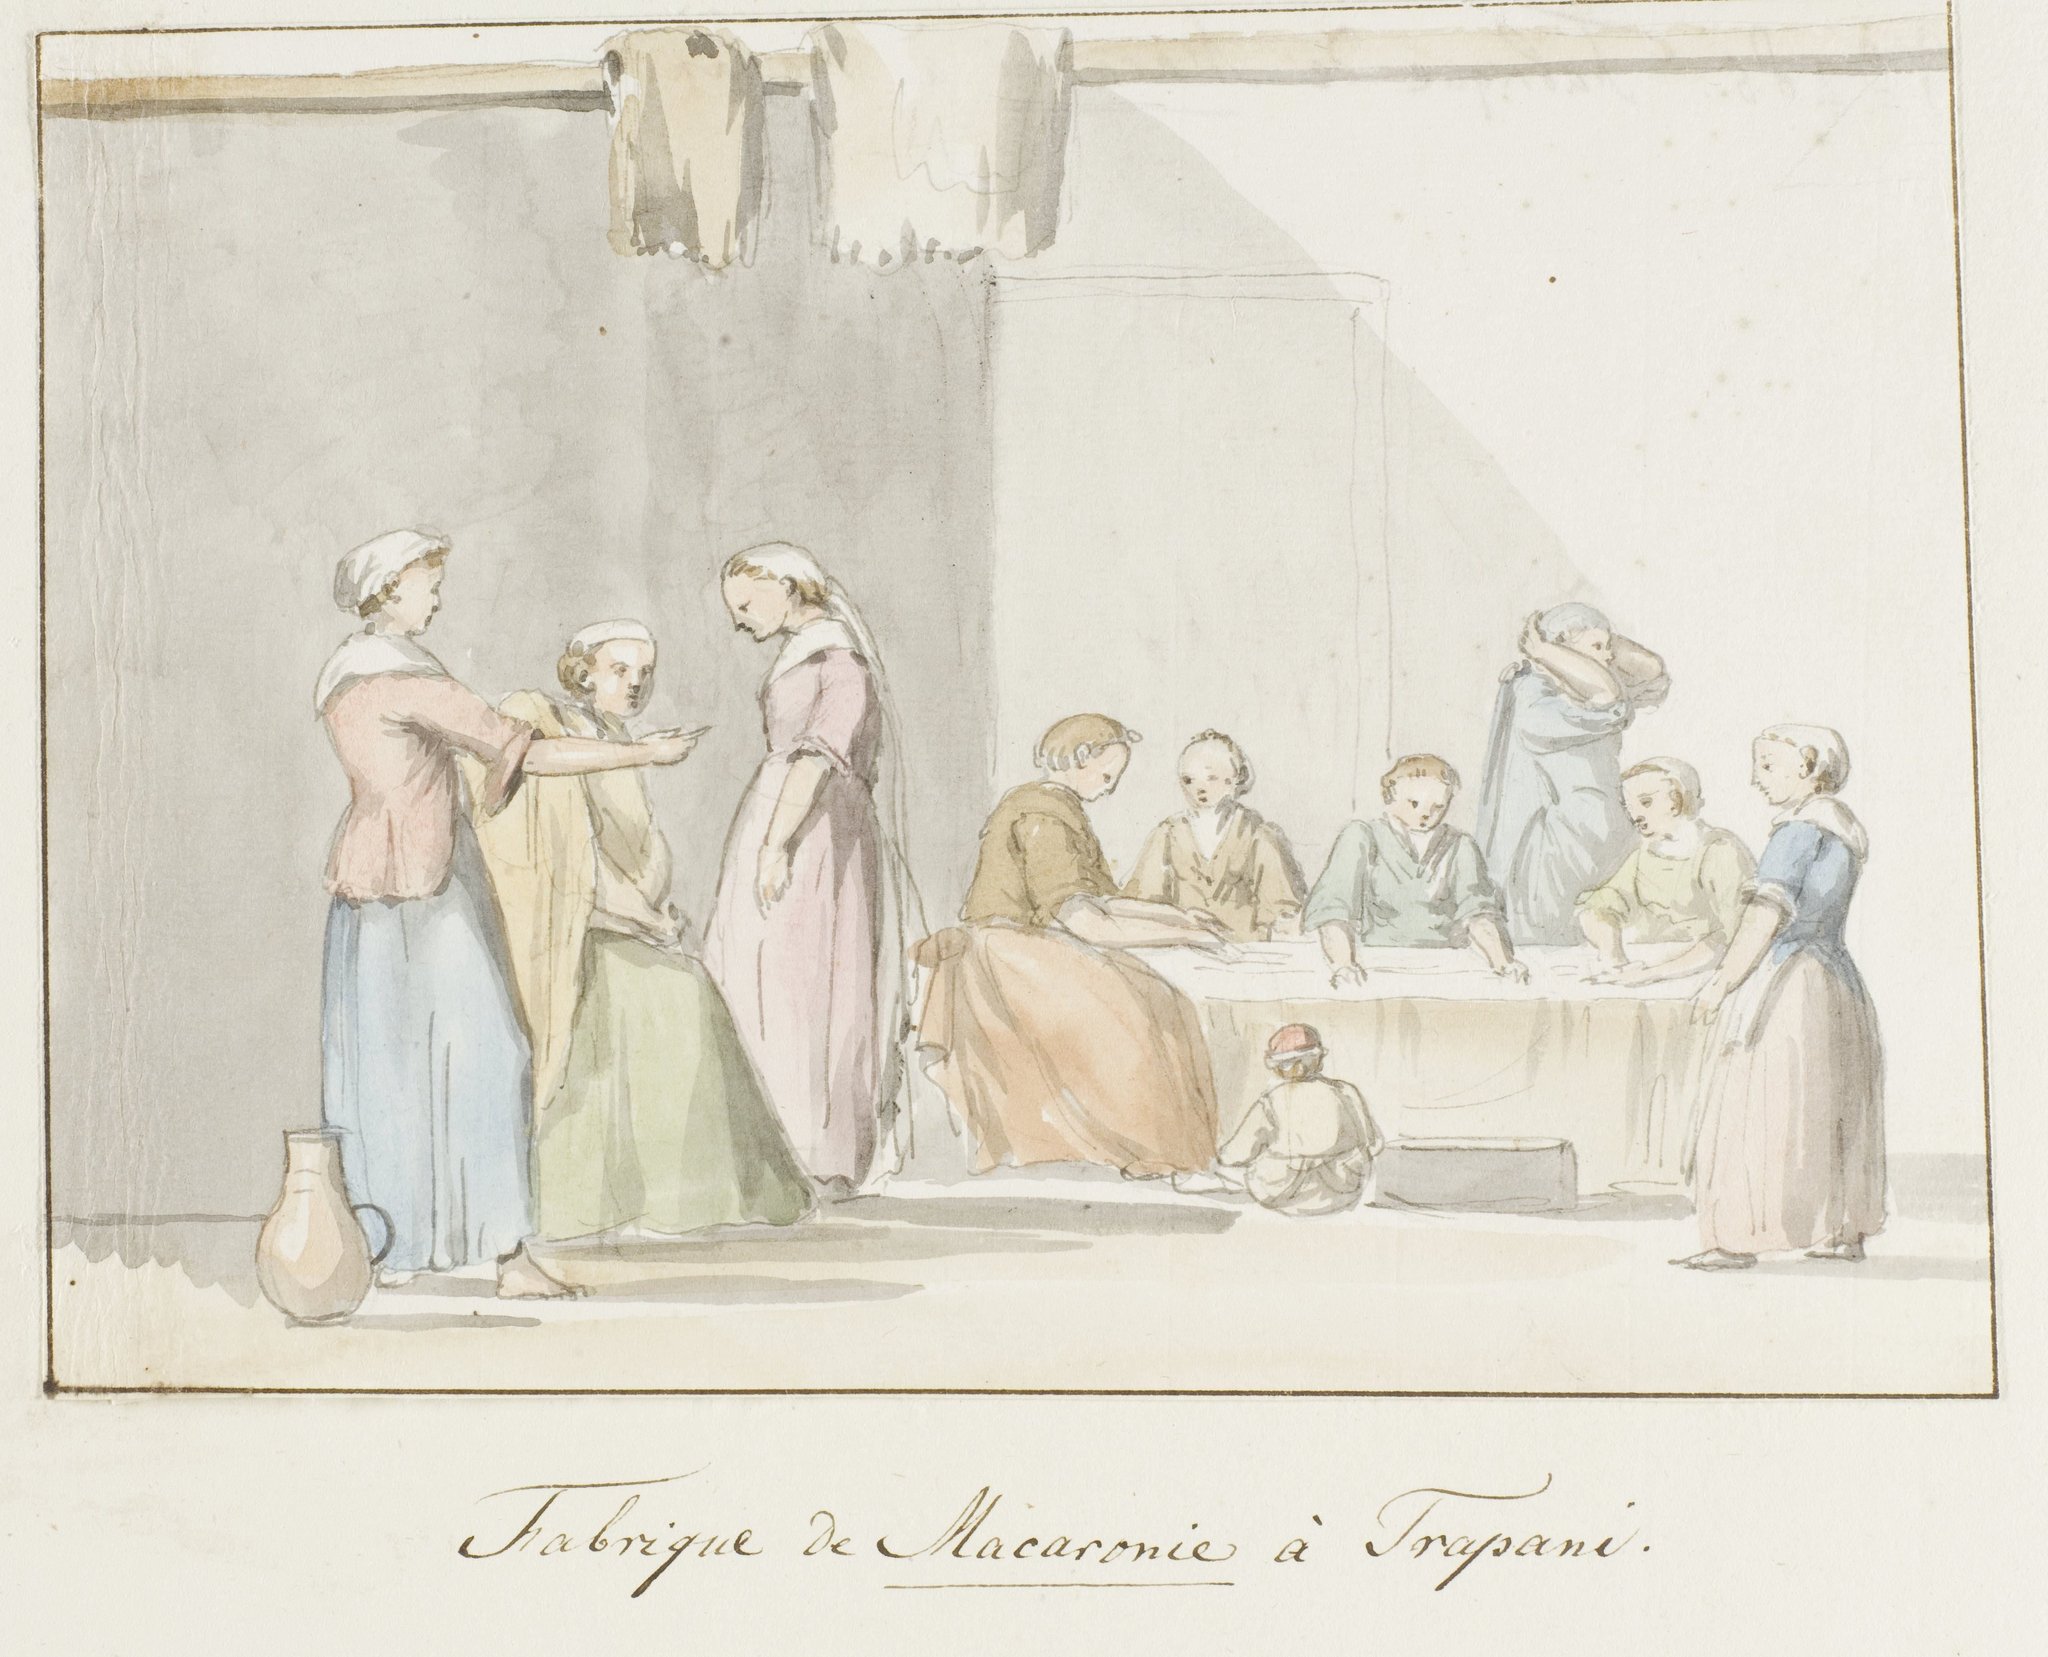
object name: drawing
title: Bereiden van de macaroni te Trapani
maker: louis ducros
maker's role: draughtsman, print maker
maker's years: 1748-1810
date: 1778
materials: chalk, paper, watercolor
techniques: brush, pen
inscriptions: inscription: ‘No 285 Fabrique de Macaroni à Trapani’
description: Tekening uit het album 'Voyage en Italie, en Sicile et à Malte', 1778.